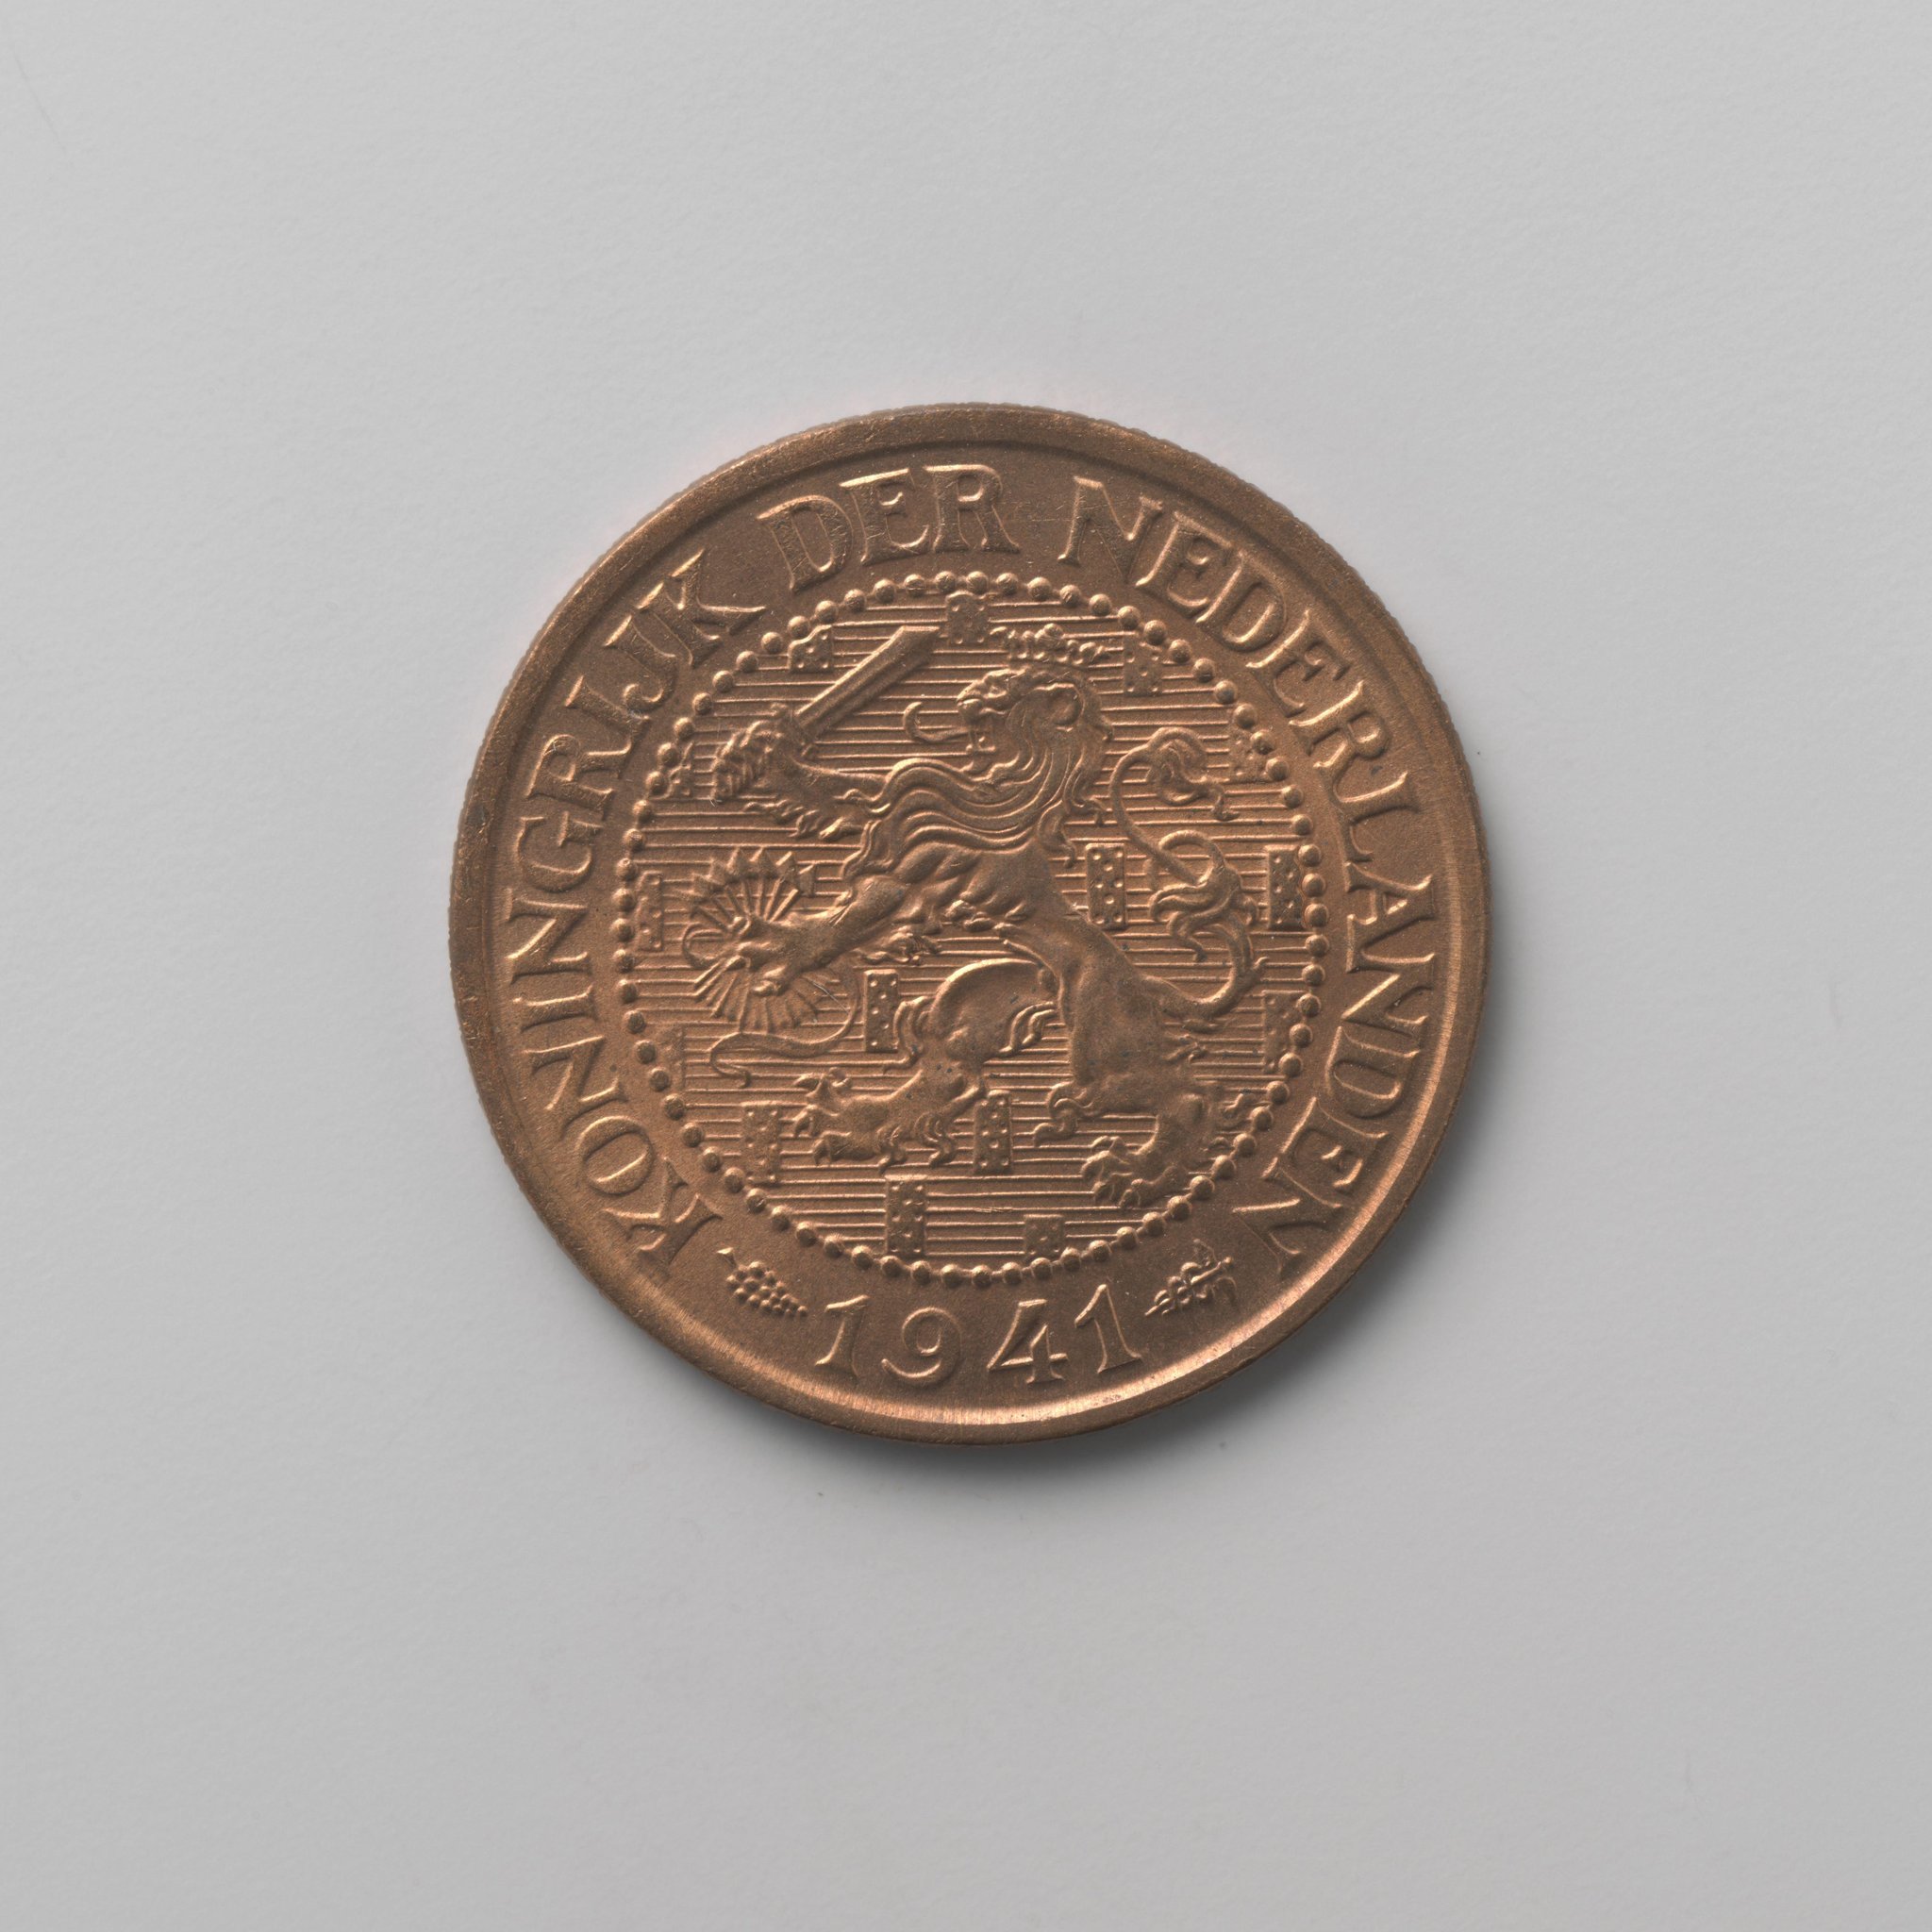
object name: coin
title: Nederlandse 2½ cent,1941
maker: wilhelmina of the netherlands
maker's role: print maker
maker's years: 1880-1962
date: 1941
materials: bronze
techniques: striking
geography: utrecht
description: Bronzen munt. Voorzijde: in een veld rijkswapen. Jaartal onderaan in omschrift.Keerzijde: binnen twee samengebonden oranjetakken waarde-aanduiding 2½ cent. Kartelrand.